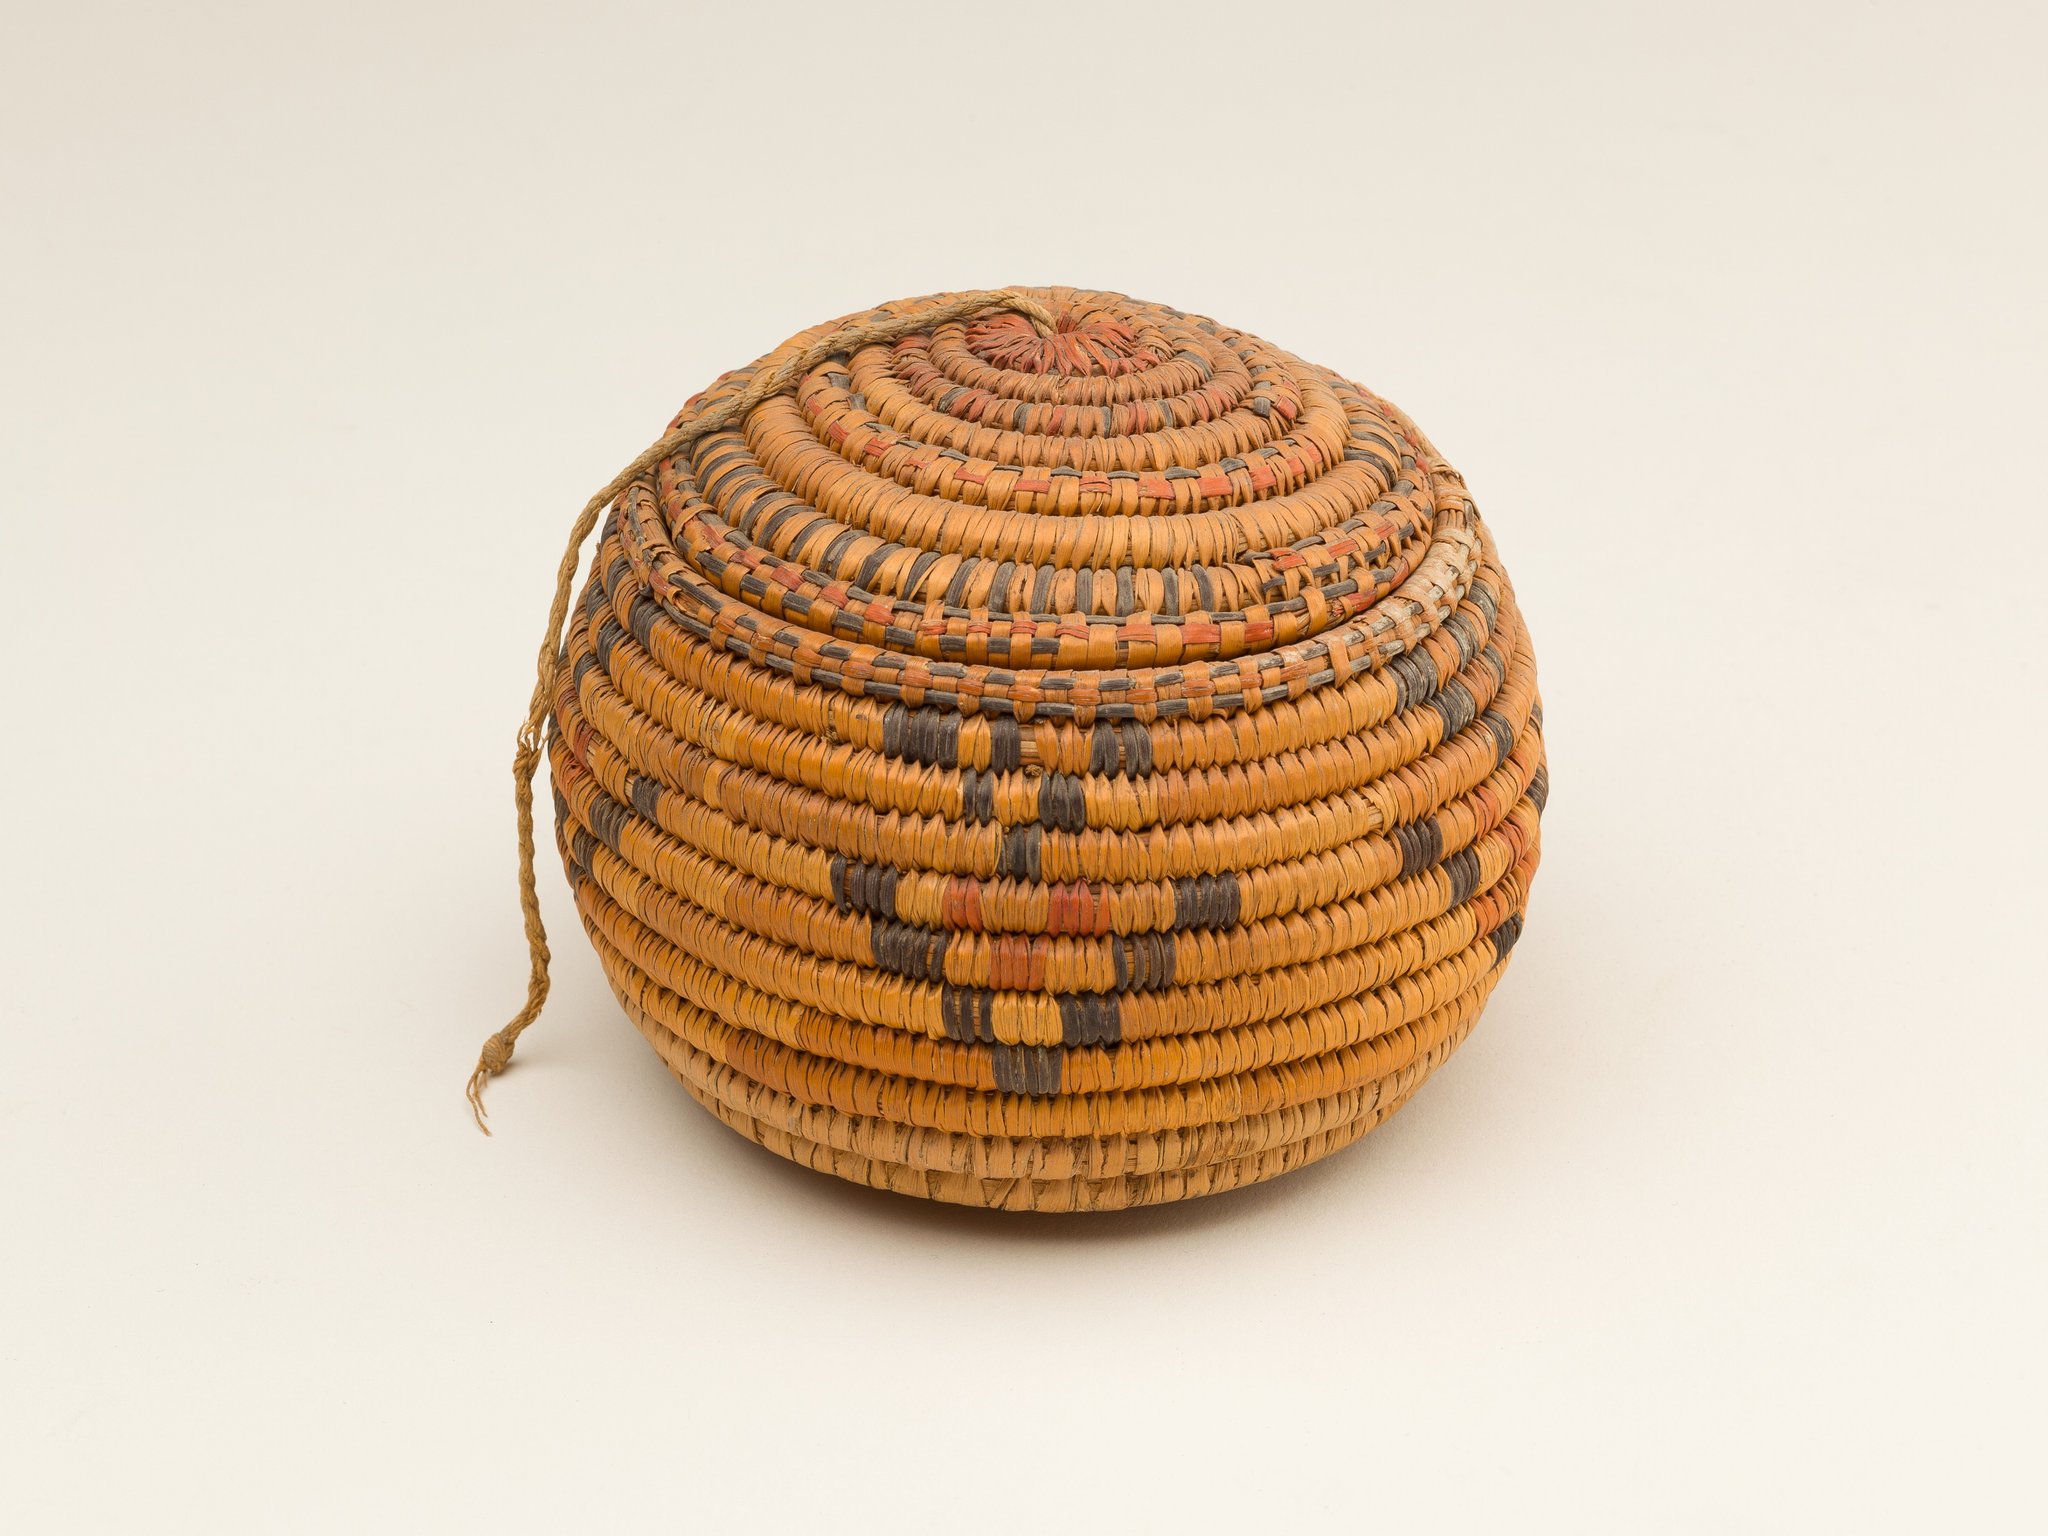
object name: basket, round, decorated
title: Small Round Lidded Basket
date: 1492-1473 BCE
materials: cord, linen, leaf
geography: egypt